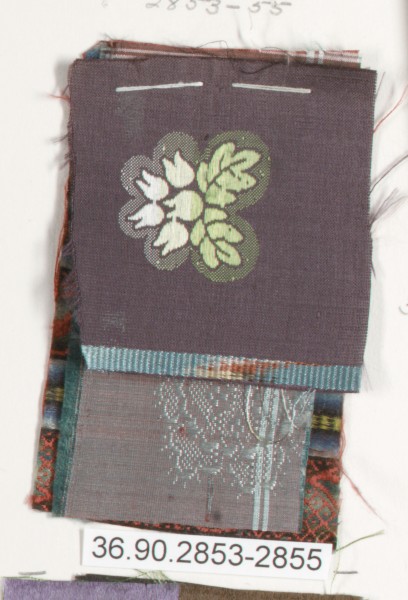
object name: piece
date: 1801-1900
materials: silk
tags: leaves